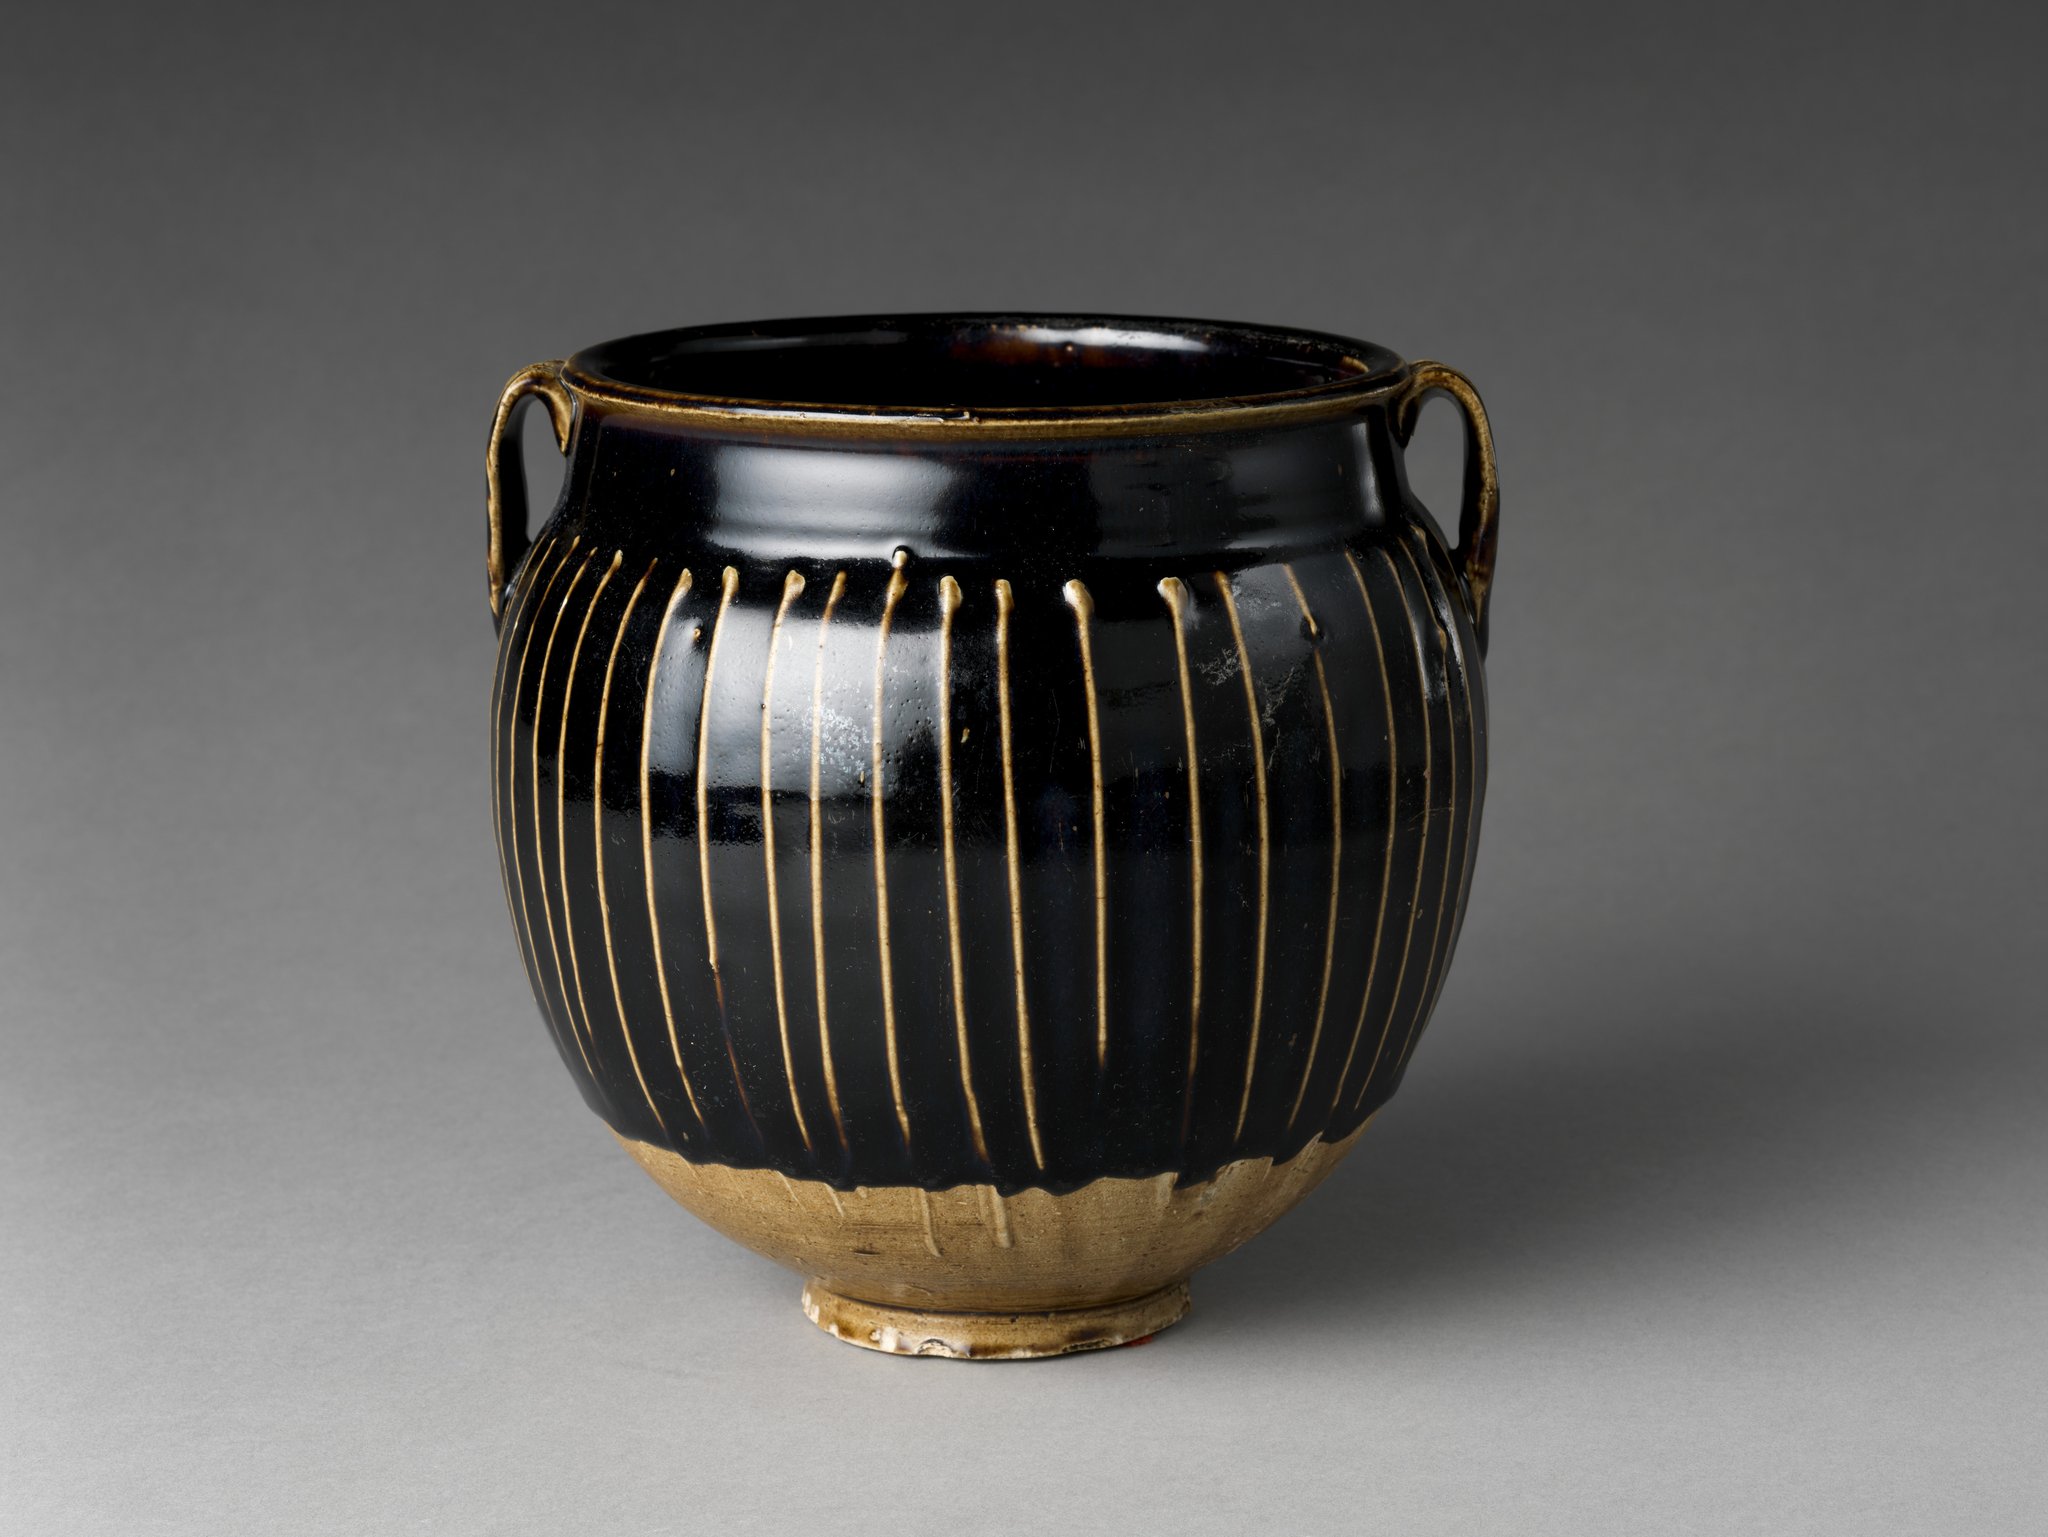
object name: jar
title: Jar with Handles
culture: chinese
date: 1101-1200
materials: glaze, stoneware